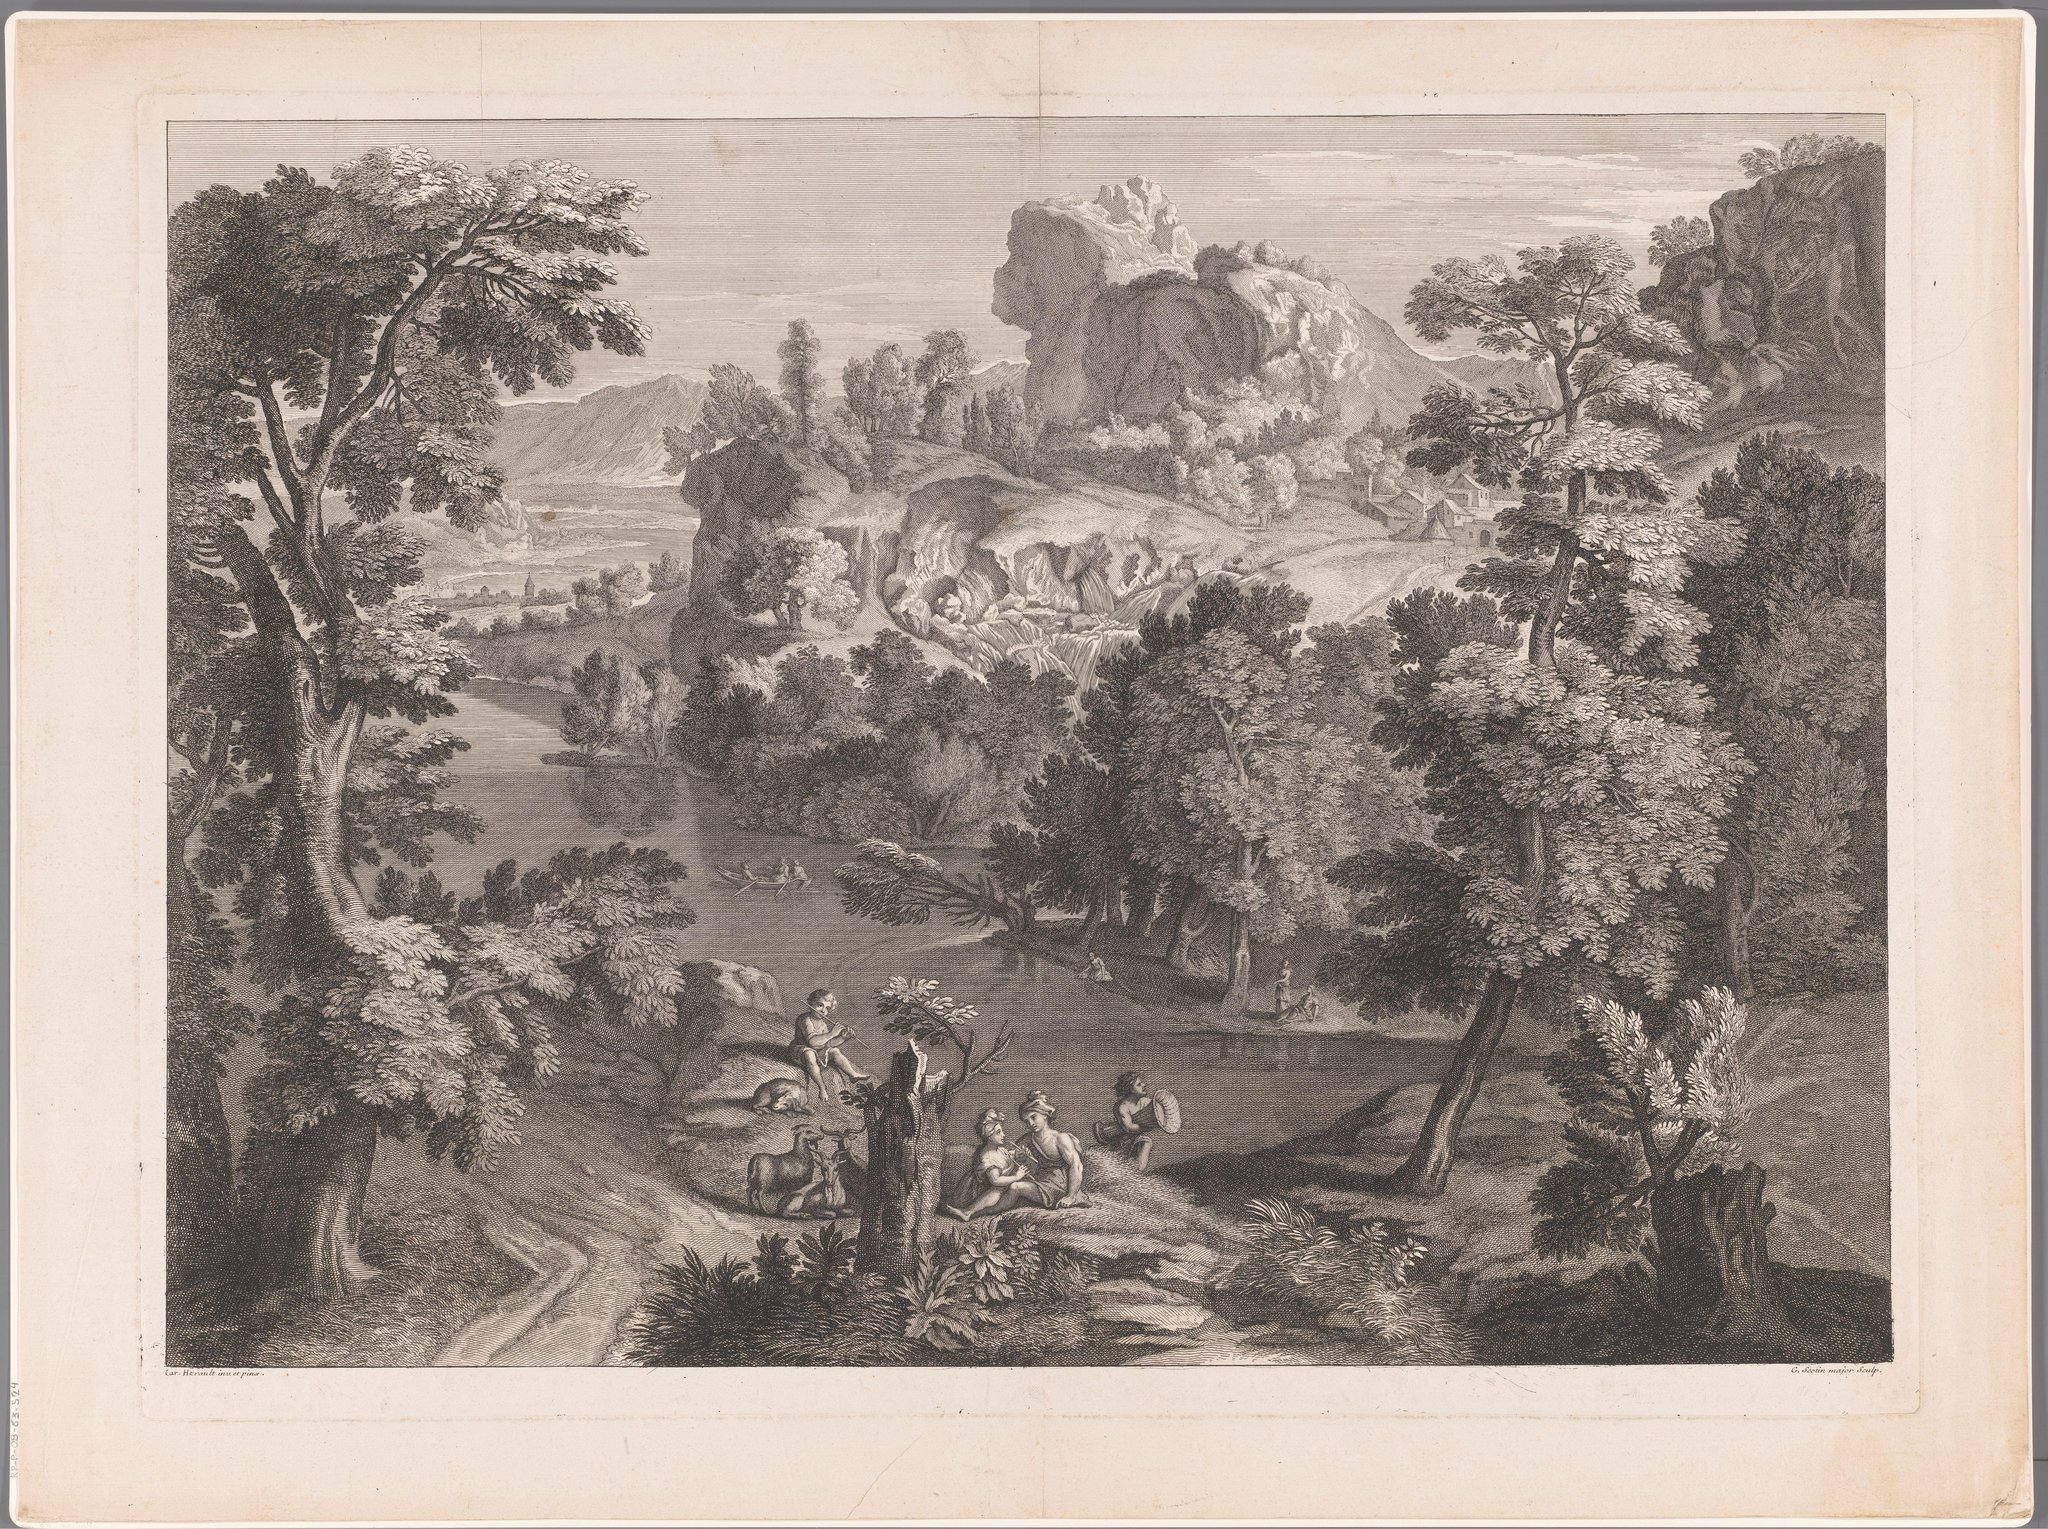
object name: print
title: Heuvelachtig landschap met herders bij een rivier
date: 1681-1716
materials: paper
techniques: engraving, etching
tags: landscapes with waters, waterscapes, seascapes (in the temperate zone)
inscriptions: collector's mark: Lugt 240